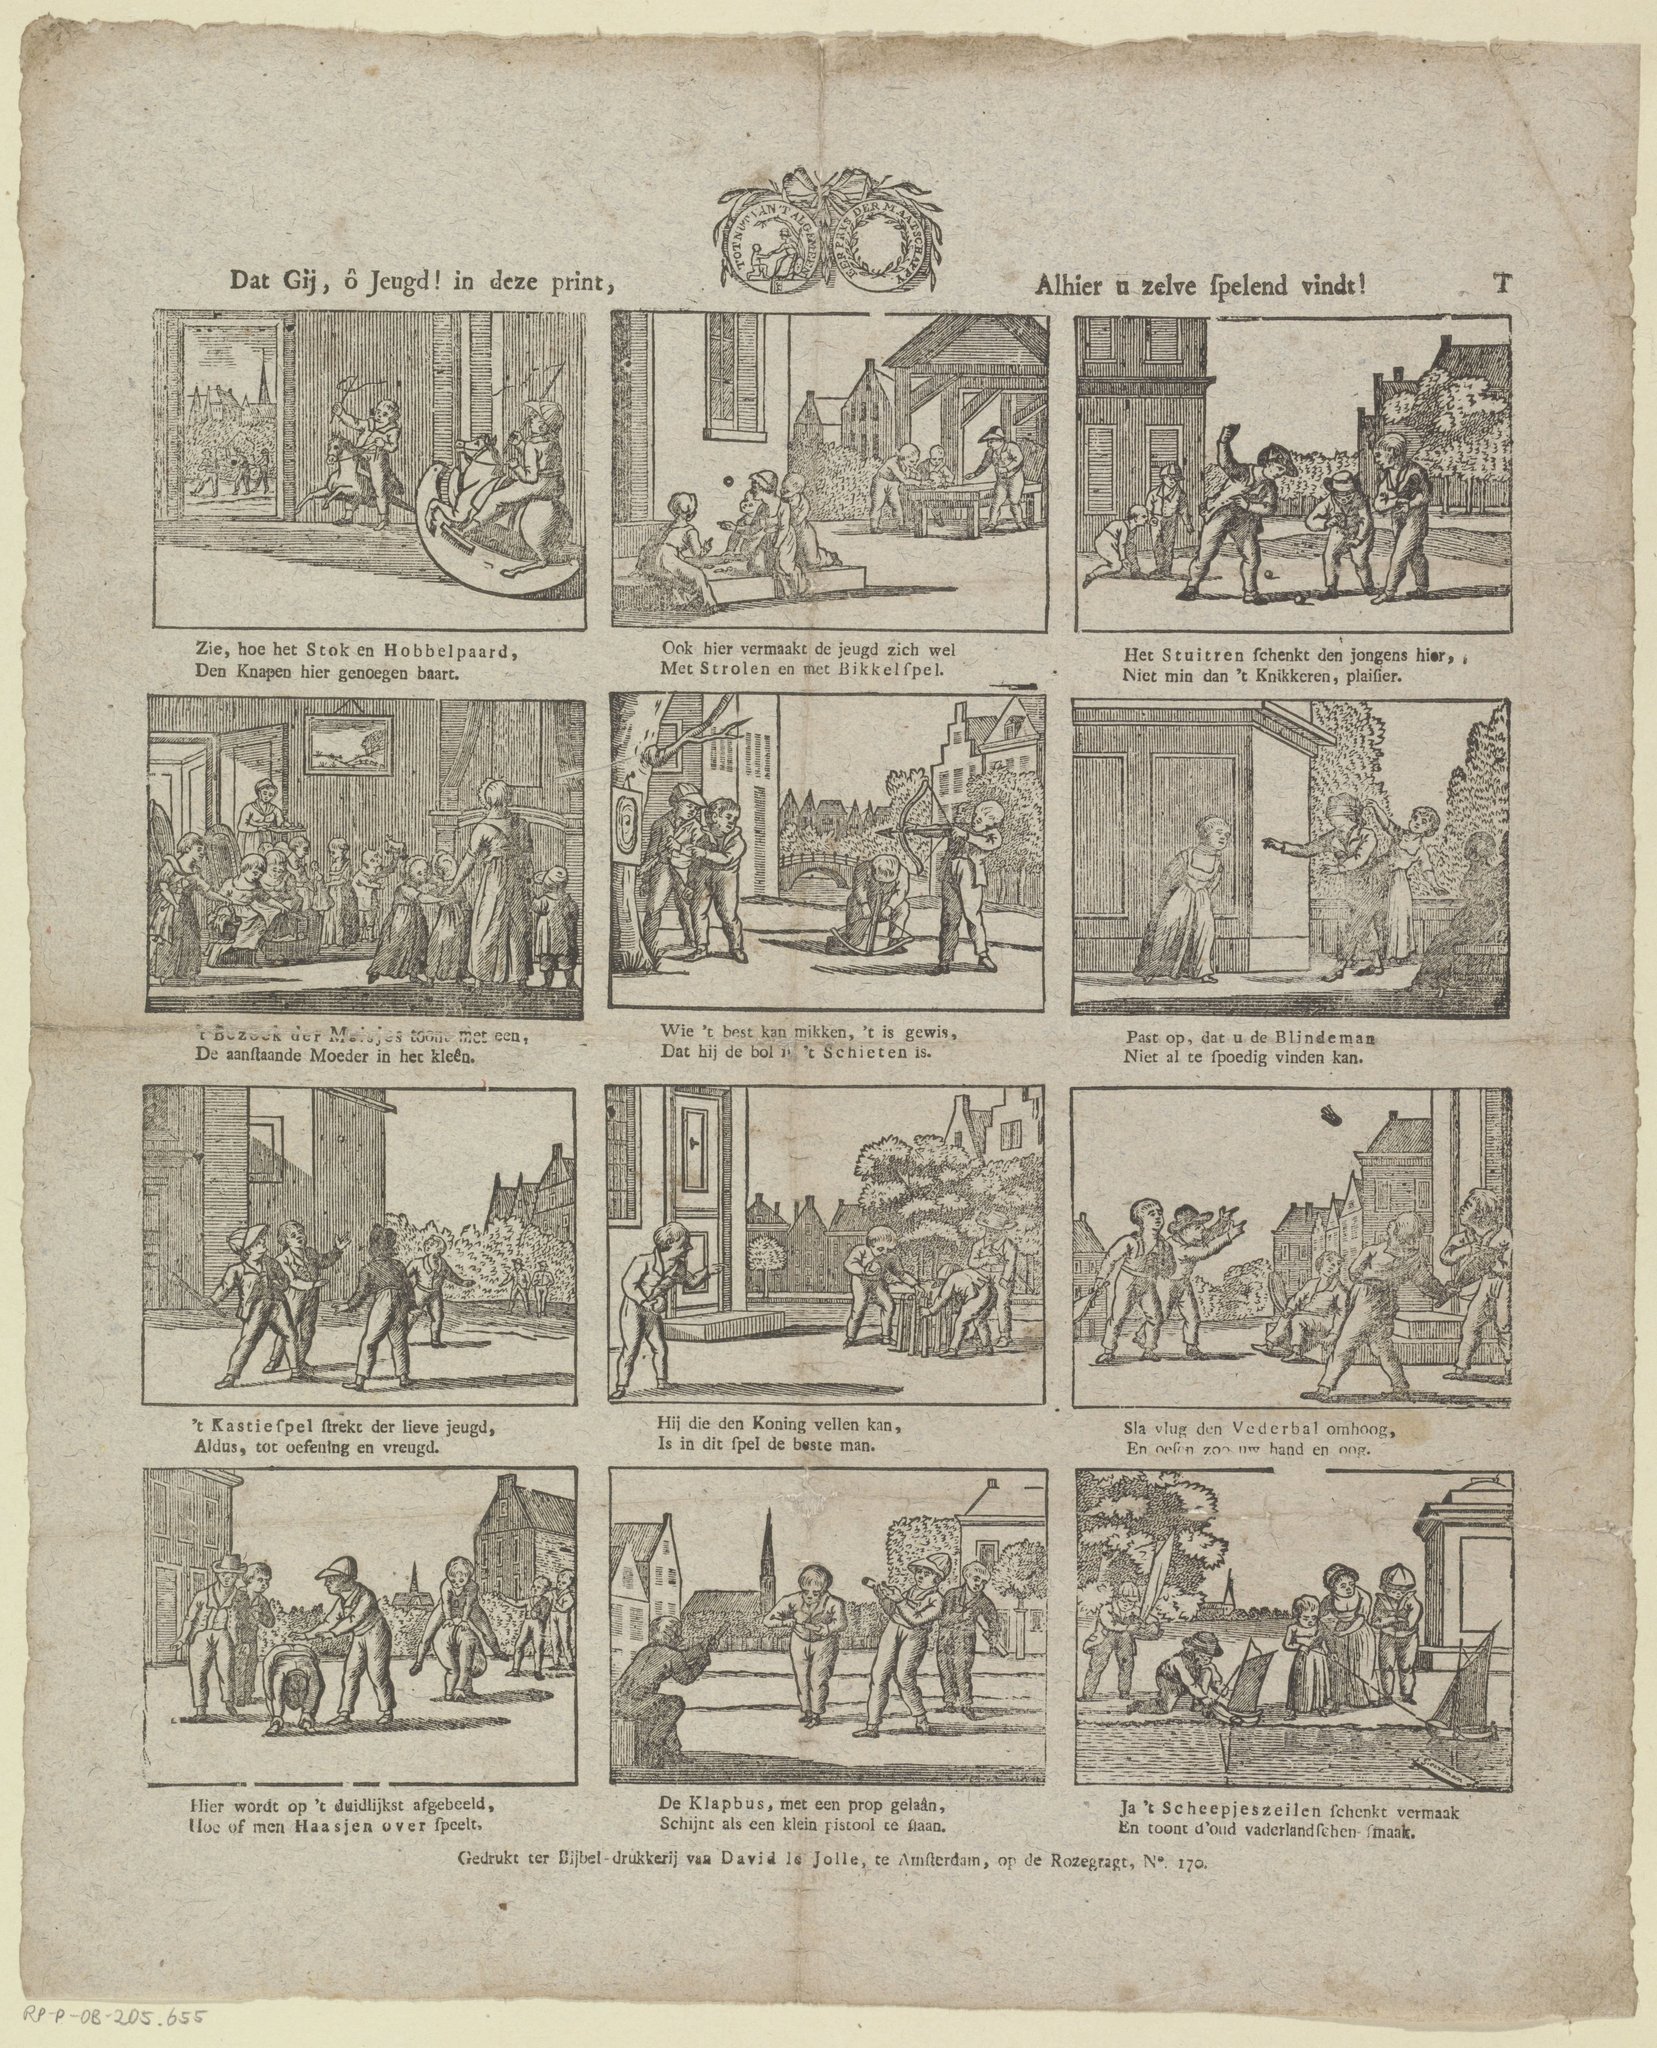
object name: popular print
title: Dat gij, ô jeugd! in deze print, / Alhier u zelve spelend vindt!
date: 1814-1820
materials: paper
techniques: letterpress printing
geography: amsterdam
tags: children's games and plays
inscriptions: collector's mark: Lugt 2760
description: Blad met 12 voorstellingen van kinderspelen. Midden boven het zegel van de Maatschappij tot Nut van 't Algemeen. Onder elke afbeelding een tweeregelig vers. Genummerd rechtsboven: T.